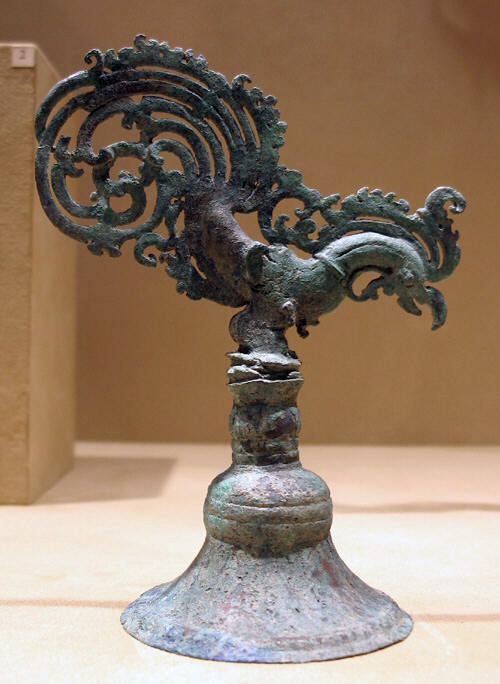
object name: finial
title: Finial with a Cockerel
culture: indonesian, javanese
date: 901-950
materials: bronze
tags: roosters